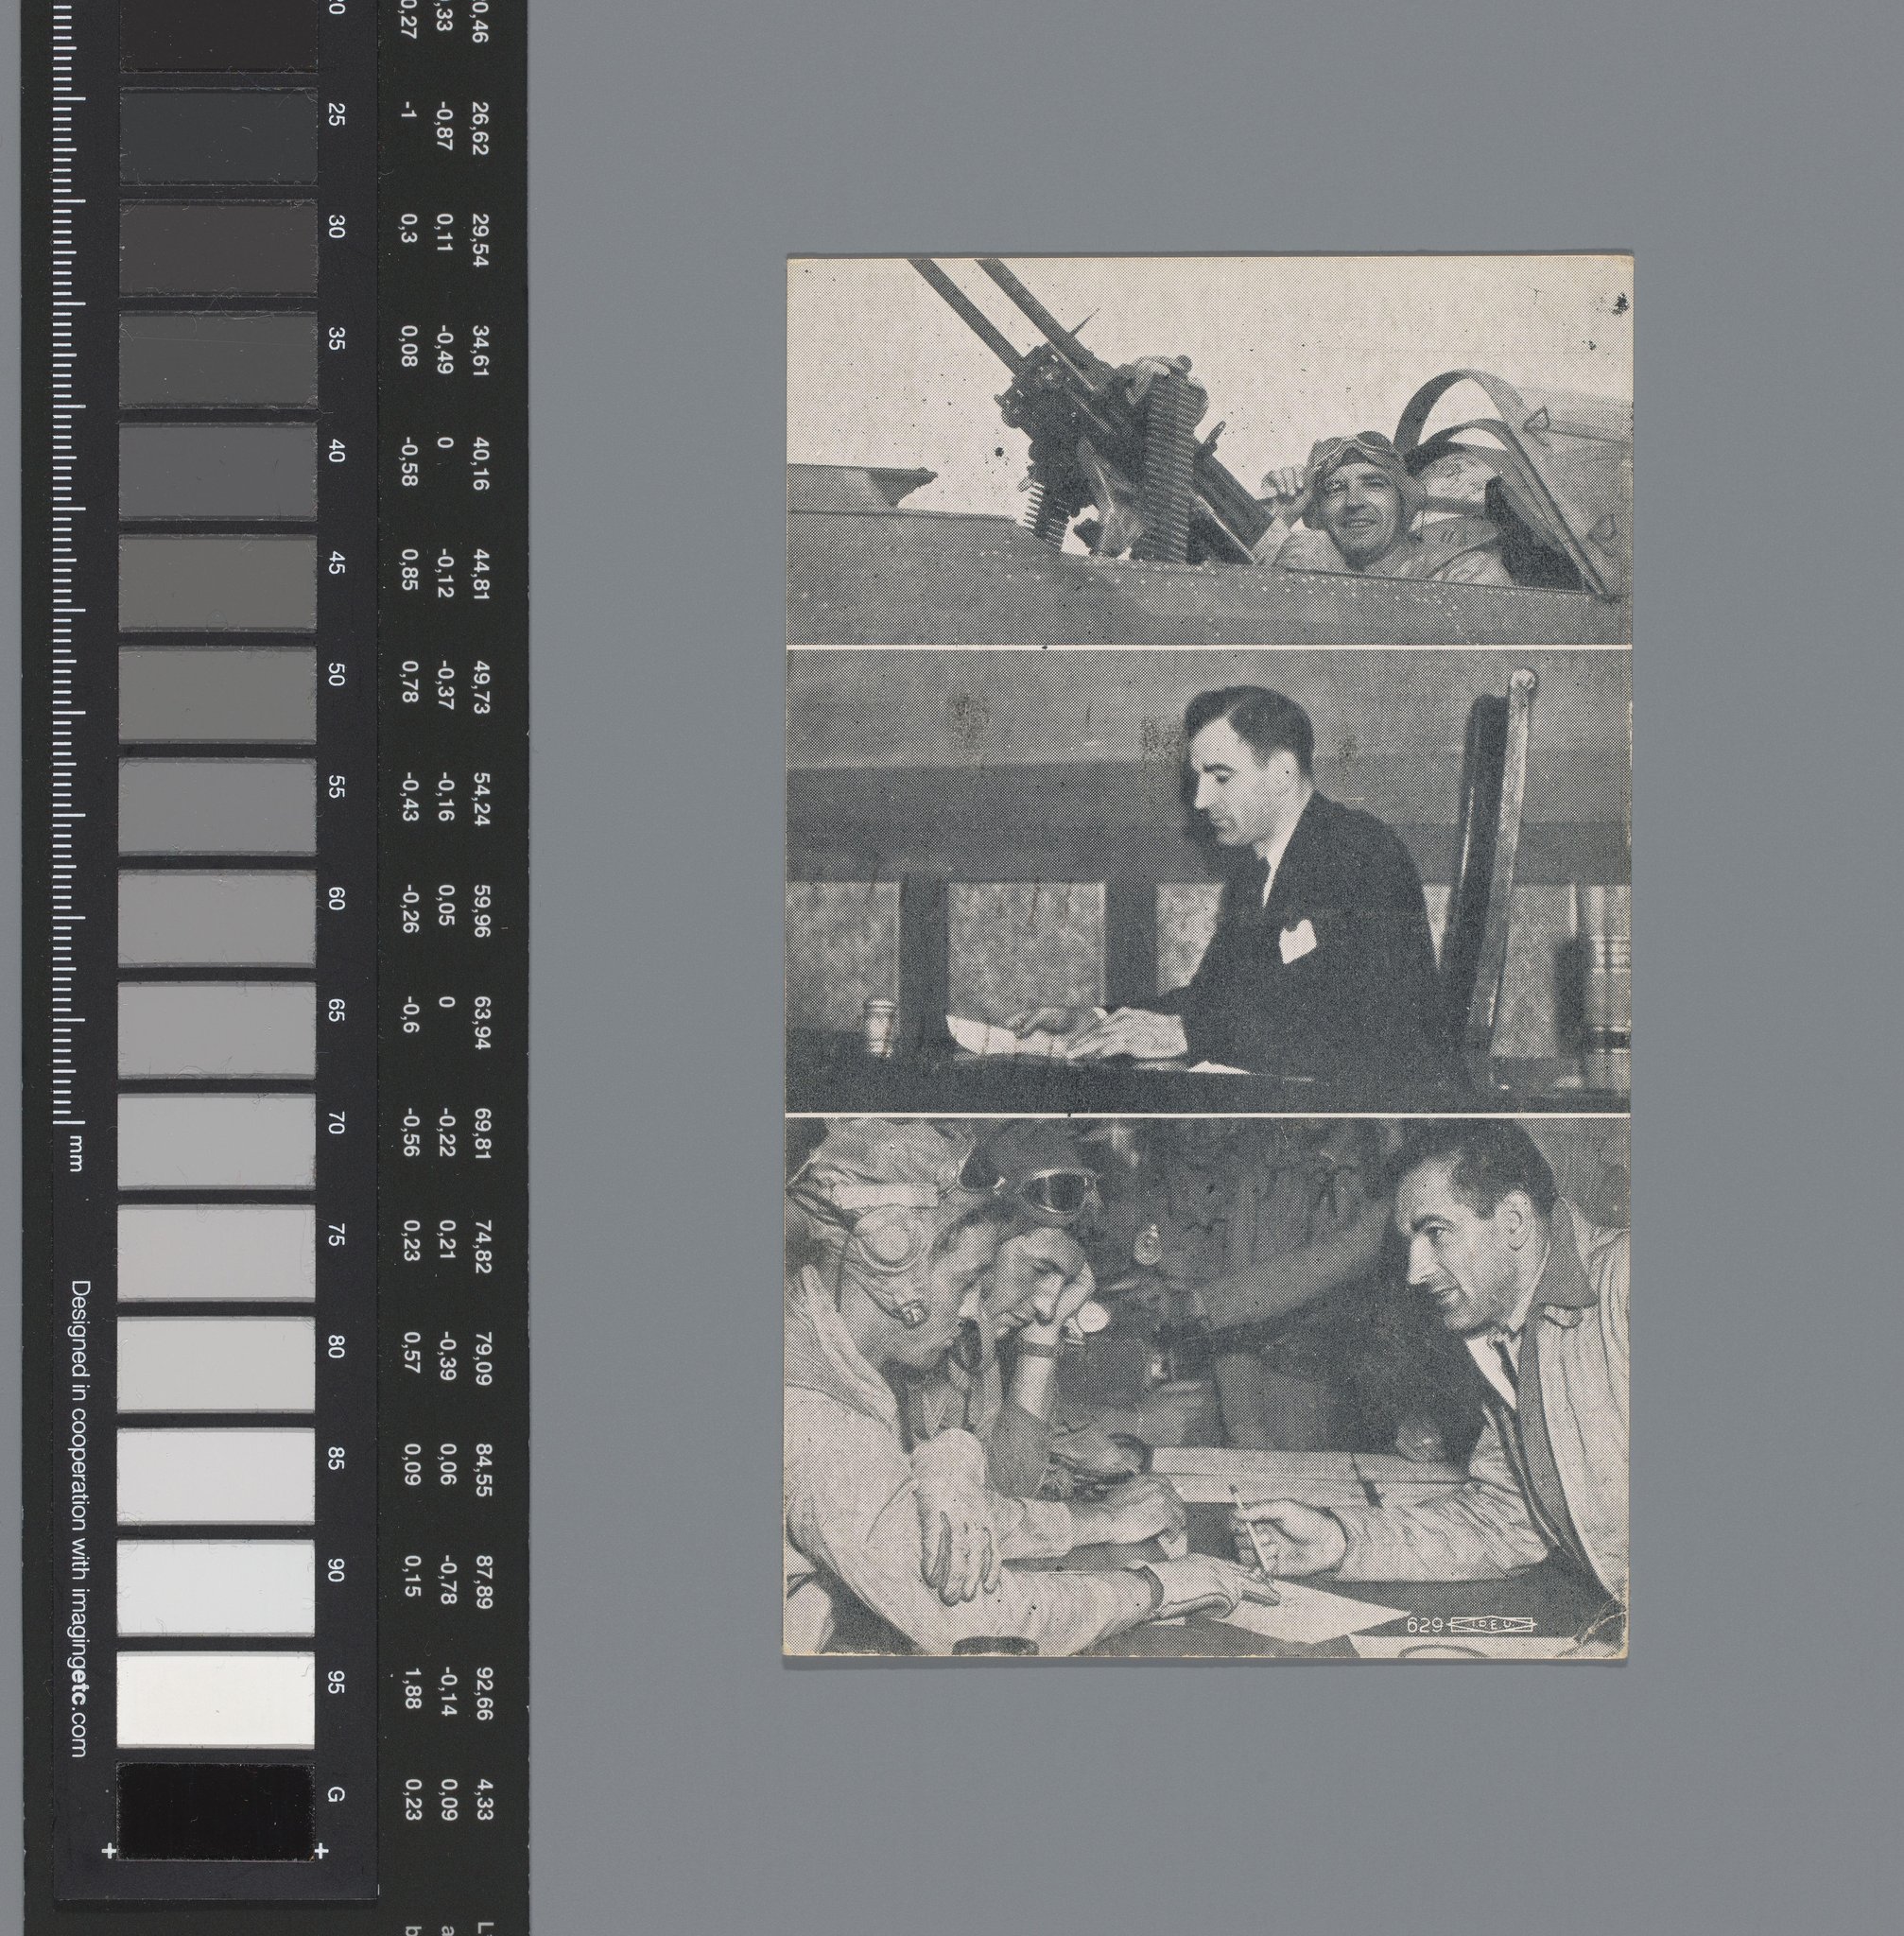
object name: ansichtkaart, prentbriefkaart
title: Prentbriefkaart gebruikt als campagnemateriaal voor senaatskandidaat Joseph McCarthy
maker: Anonymous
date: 1946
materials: photographic support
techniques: photography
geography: united states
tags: politician, united states of america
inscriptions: inscription: ‘McCARTHY FOR SENATOR / AUTH. & PAID, MCCARTHY SEN, CLUB U. VAN SUSTEREN, SEC’Y, APPLETON’